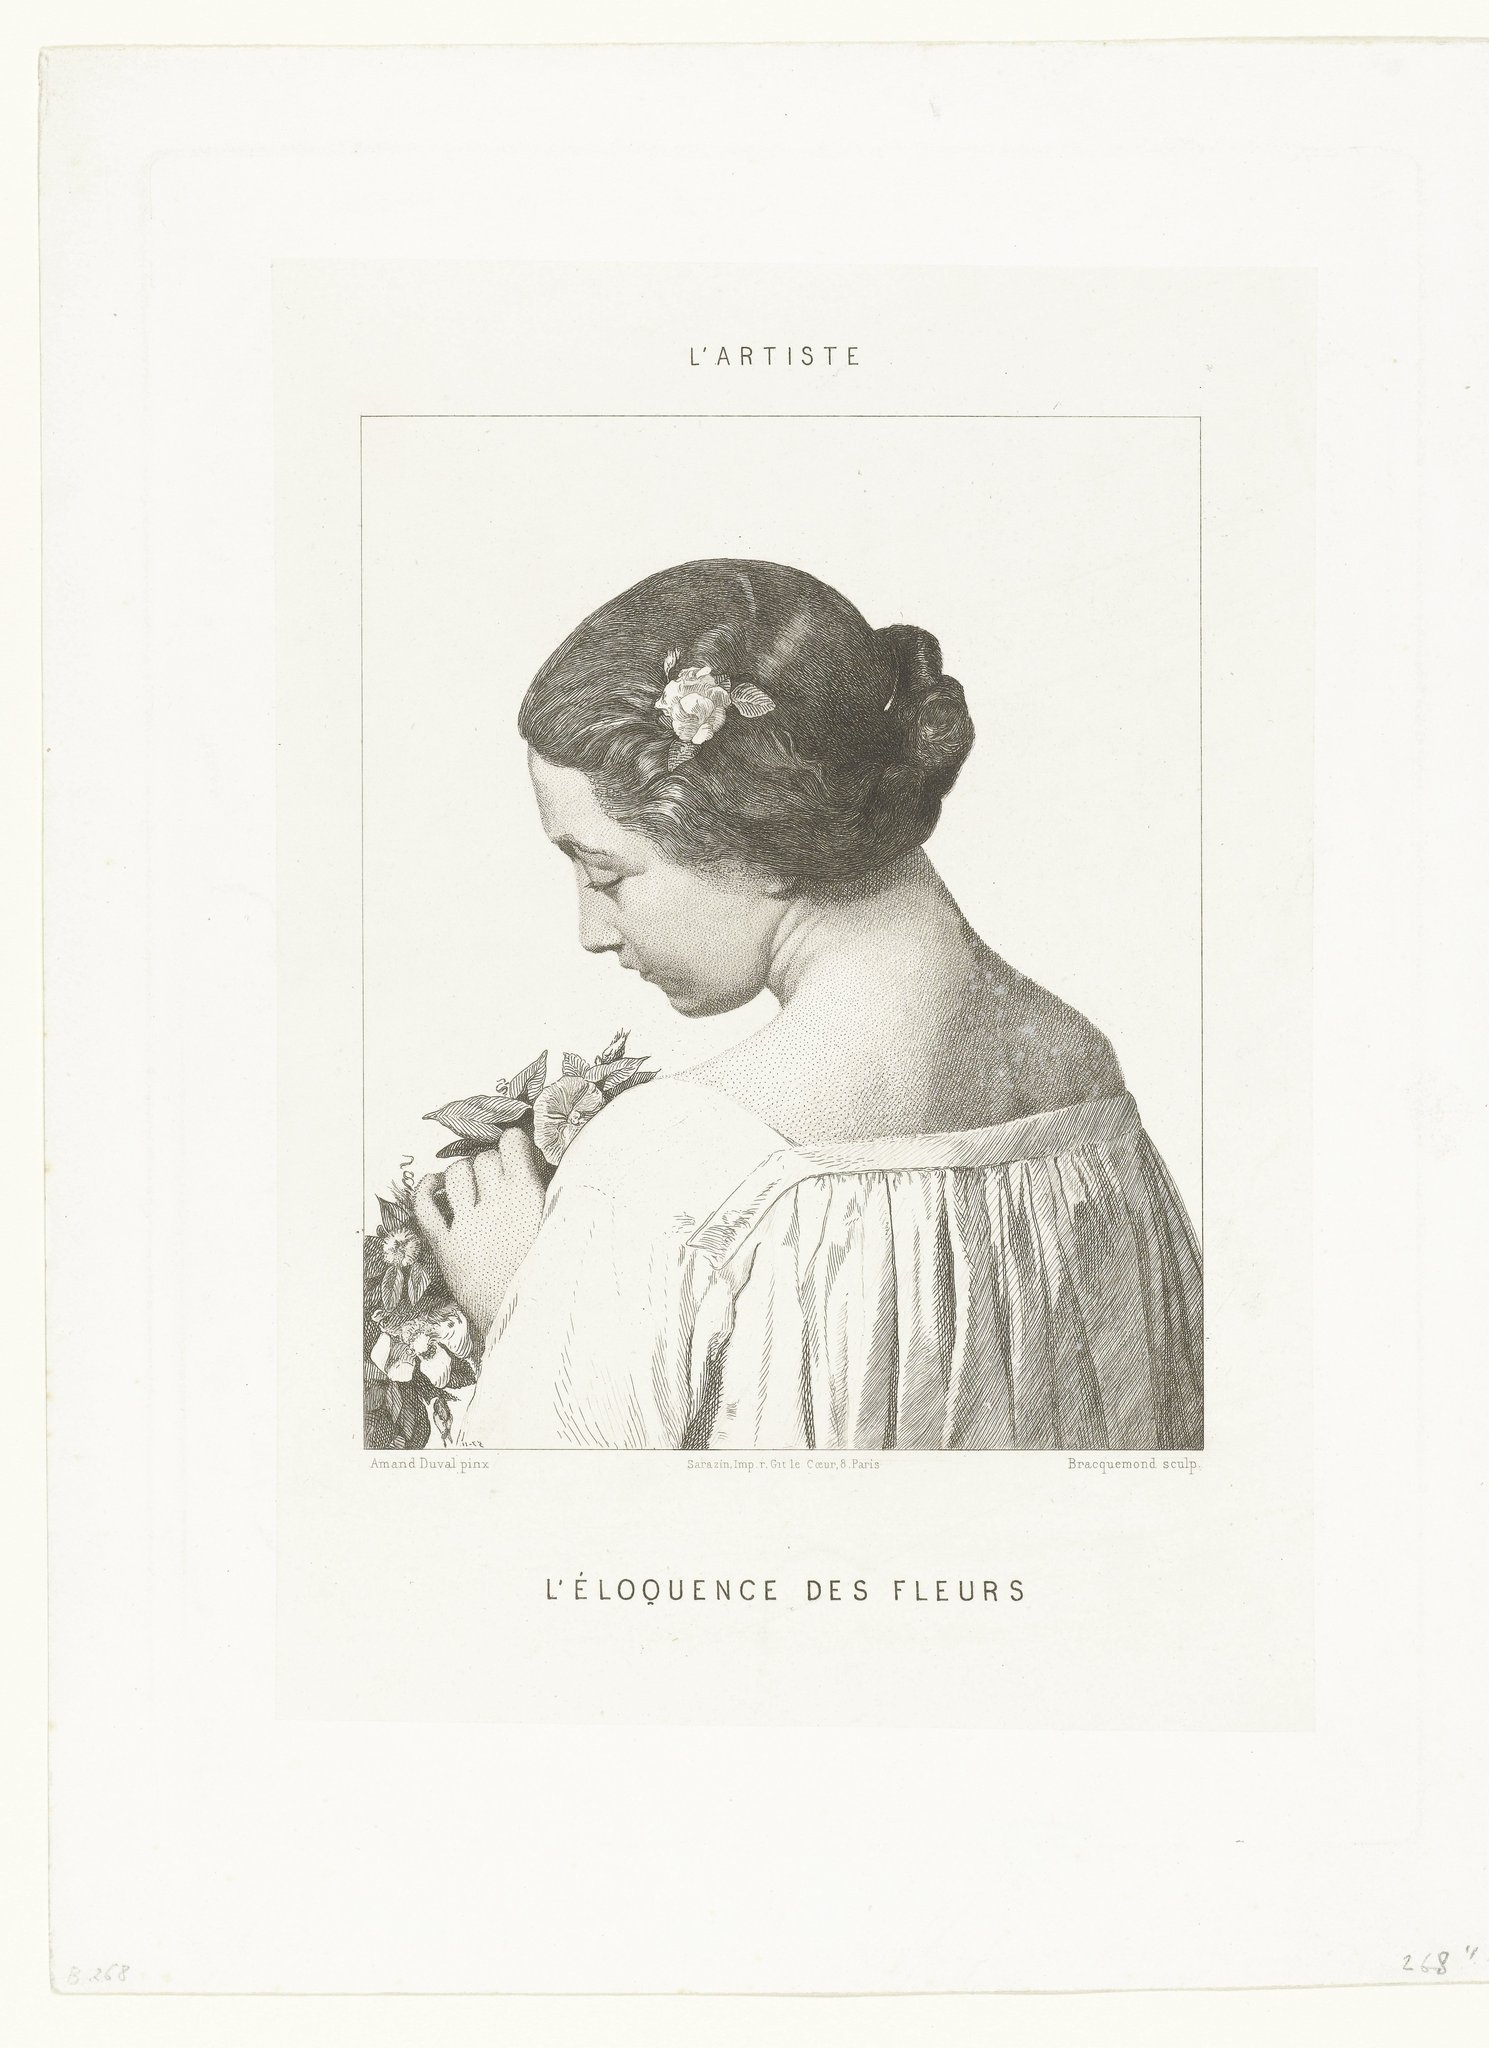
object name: print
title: Vrouw met bloemen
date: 1857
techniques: printmaking, etching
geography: paris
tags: flowers, female sex; woman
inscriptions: collector's mark: Lugt 2228, collector's mark: Lugt 2760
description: Ets naar werk van Amaury Duval. Gepresenteerd tijdens de Salon van 1857 en gepubliceerd in L'Artiste, Sarazin (drukker), Parijs 24 april 1859